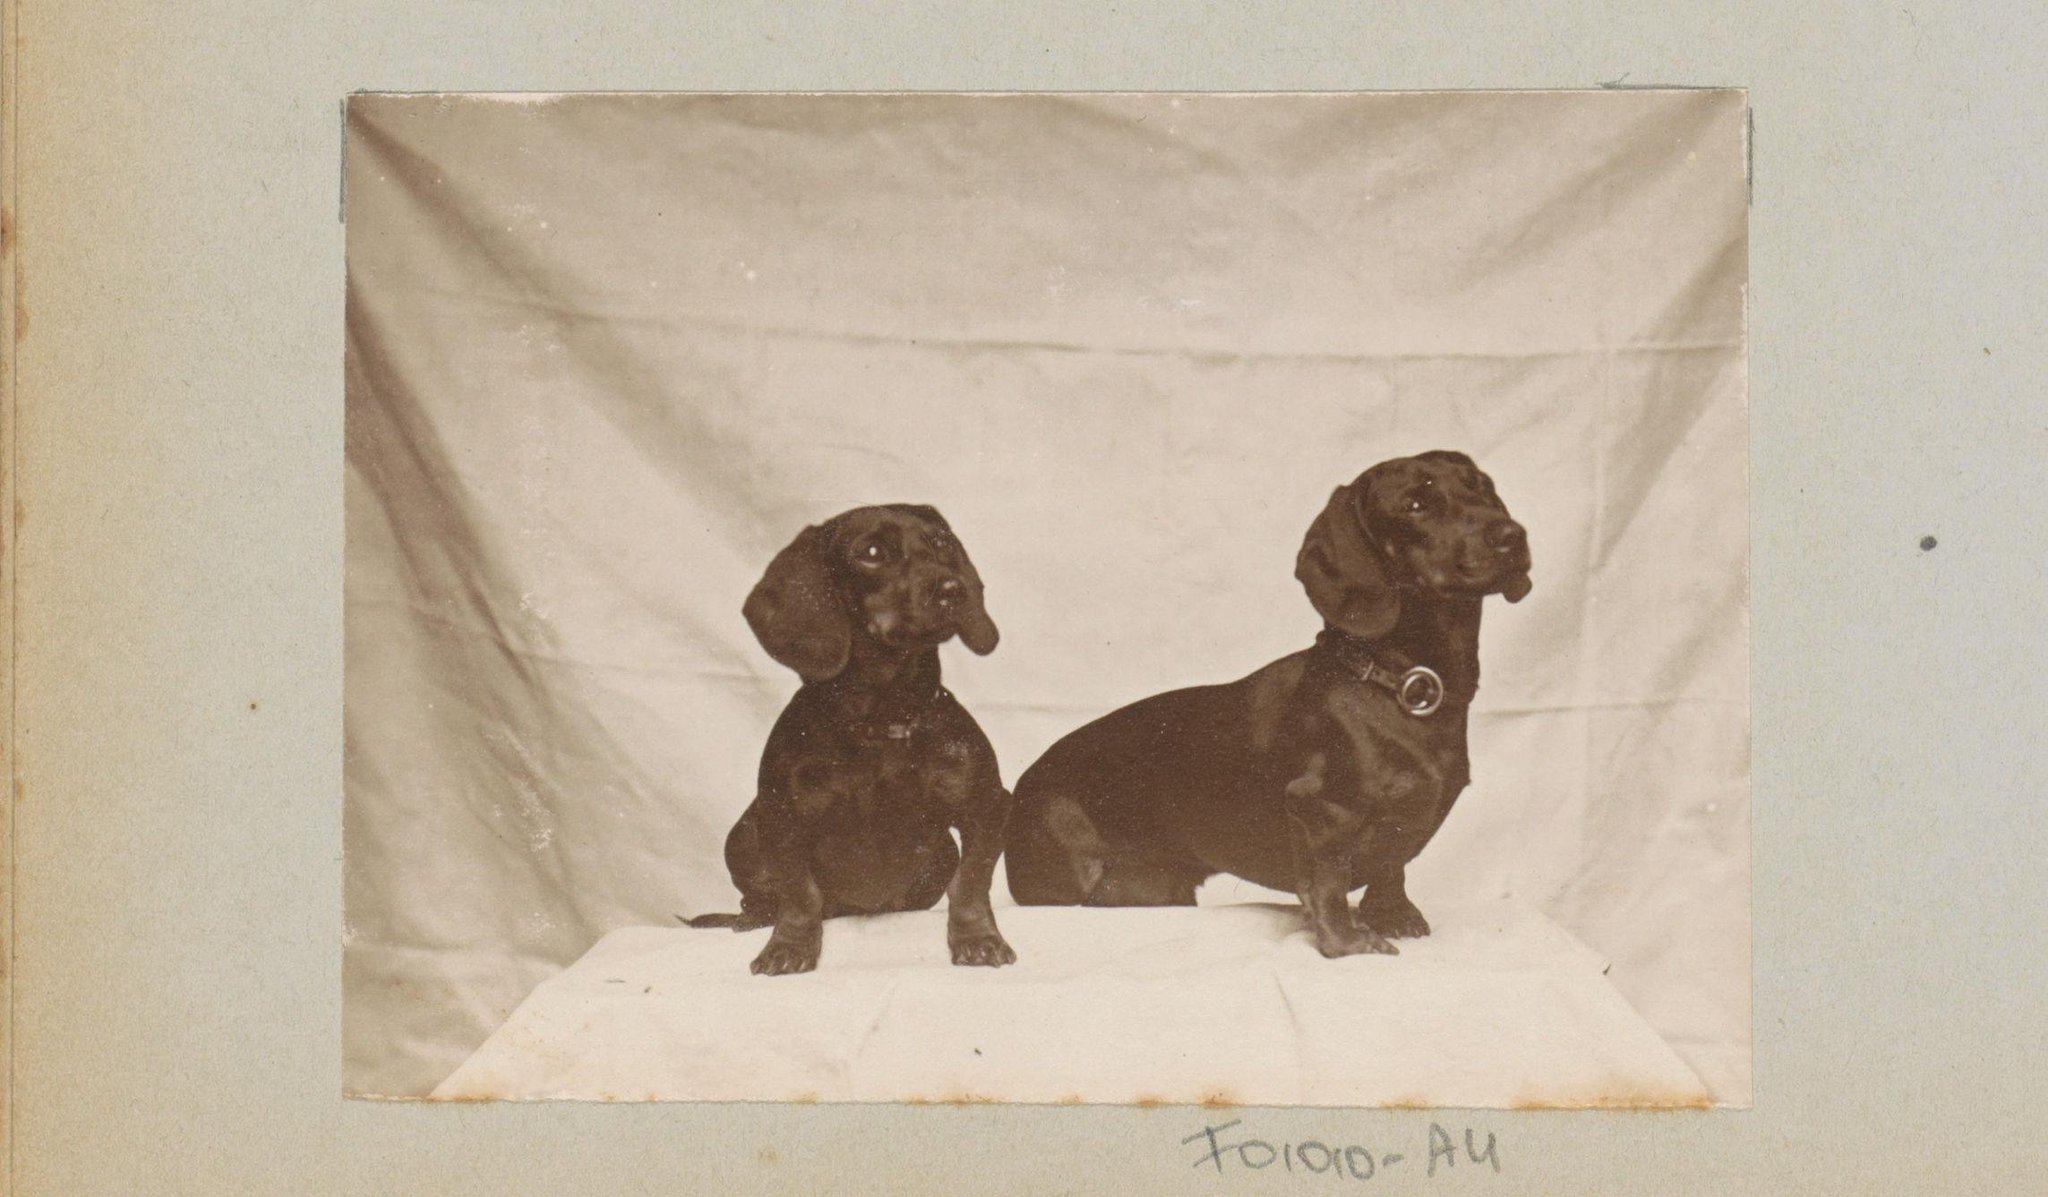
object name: photograph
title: Twee takshonden zittend voor een wit laken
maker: Anonymous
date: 1900-1910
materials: photographic support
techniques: gelatin silver print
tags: dog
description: Onderdeel van Familiealbum met onder meer foto's van Wijnhandel Kraaij & Co. Bordeaux-Amsterdam.